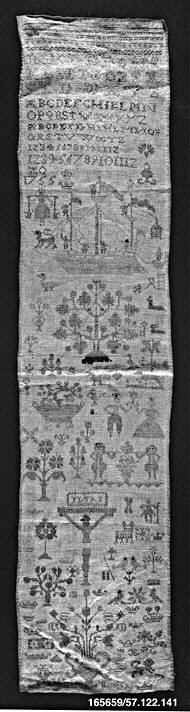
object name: sampler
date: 1755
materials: linen, silk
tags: trees,jesus